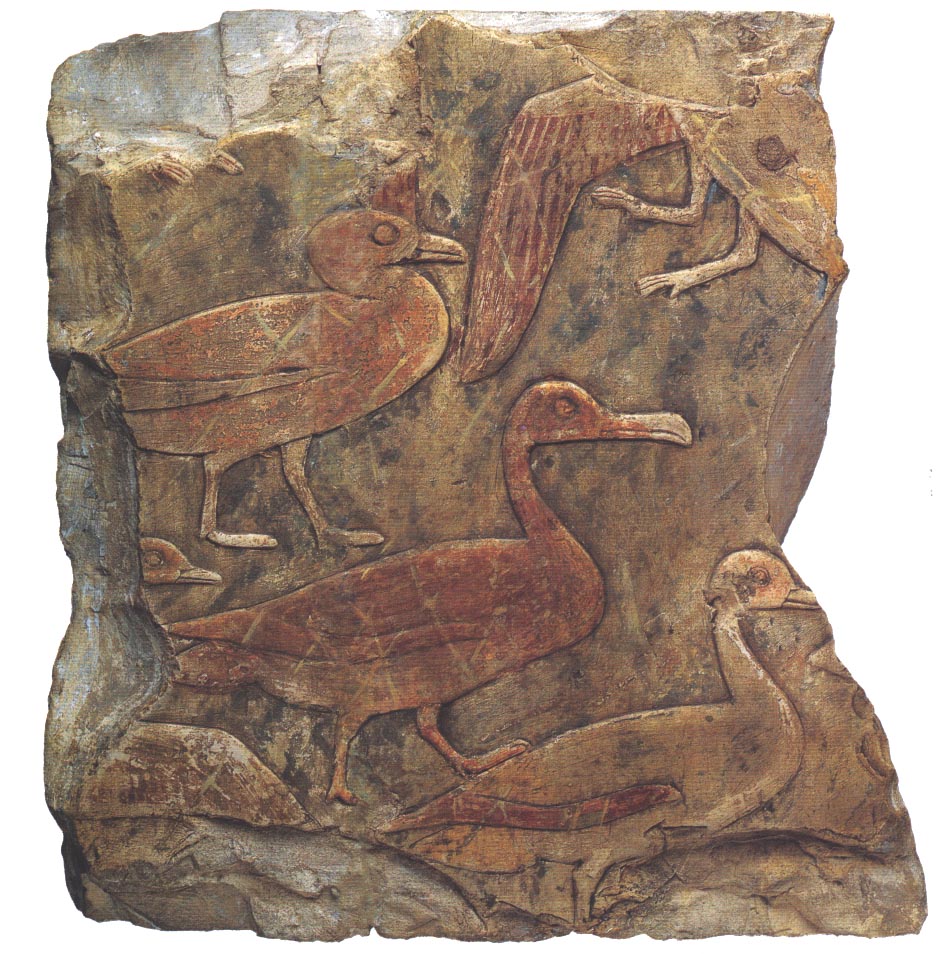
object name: relief, water fowl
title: Relief Fragment Showing Waterfowl in a Clapnet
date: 2020-2000 BCE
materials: limestone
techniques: painting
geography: egypt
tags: birds